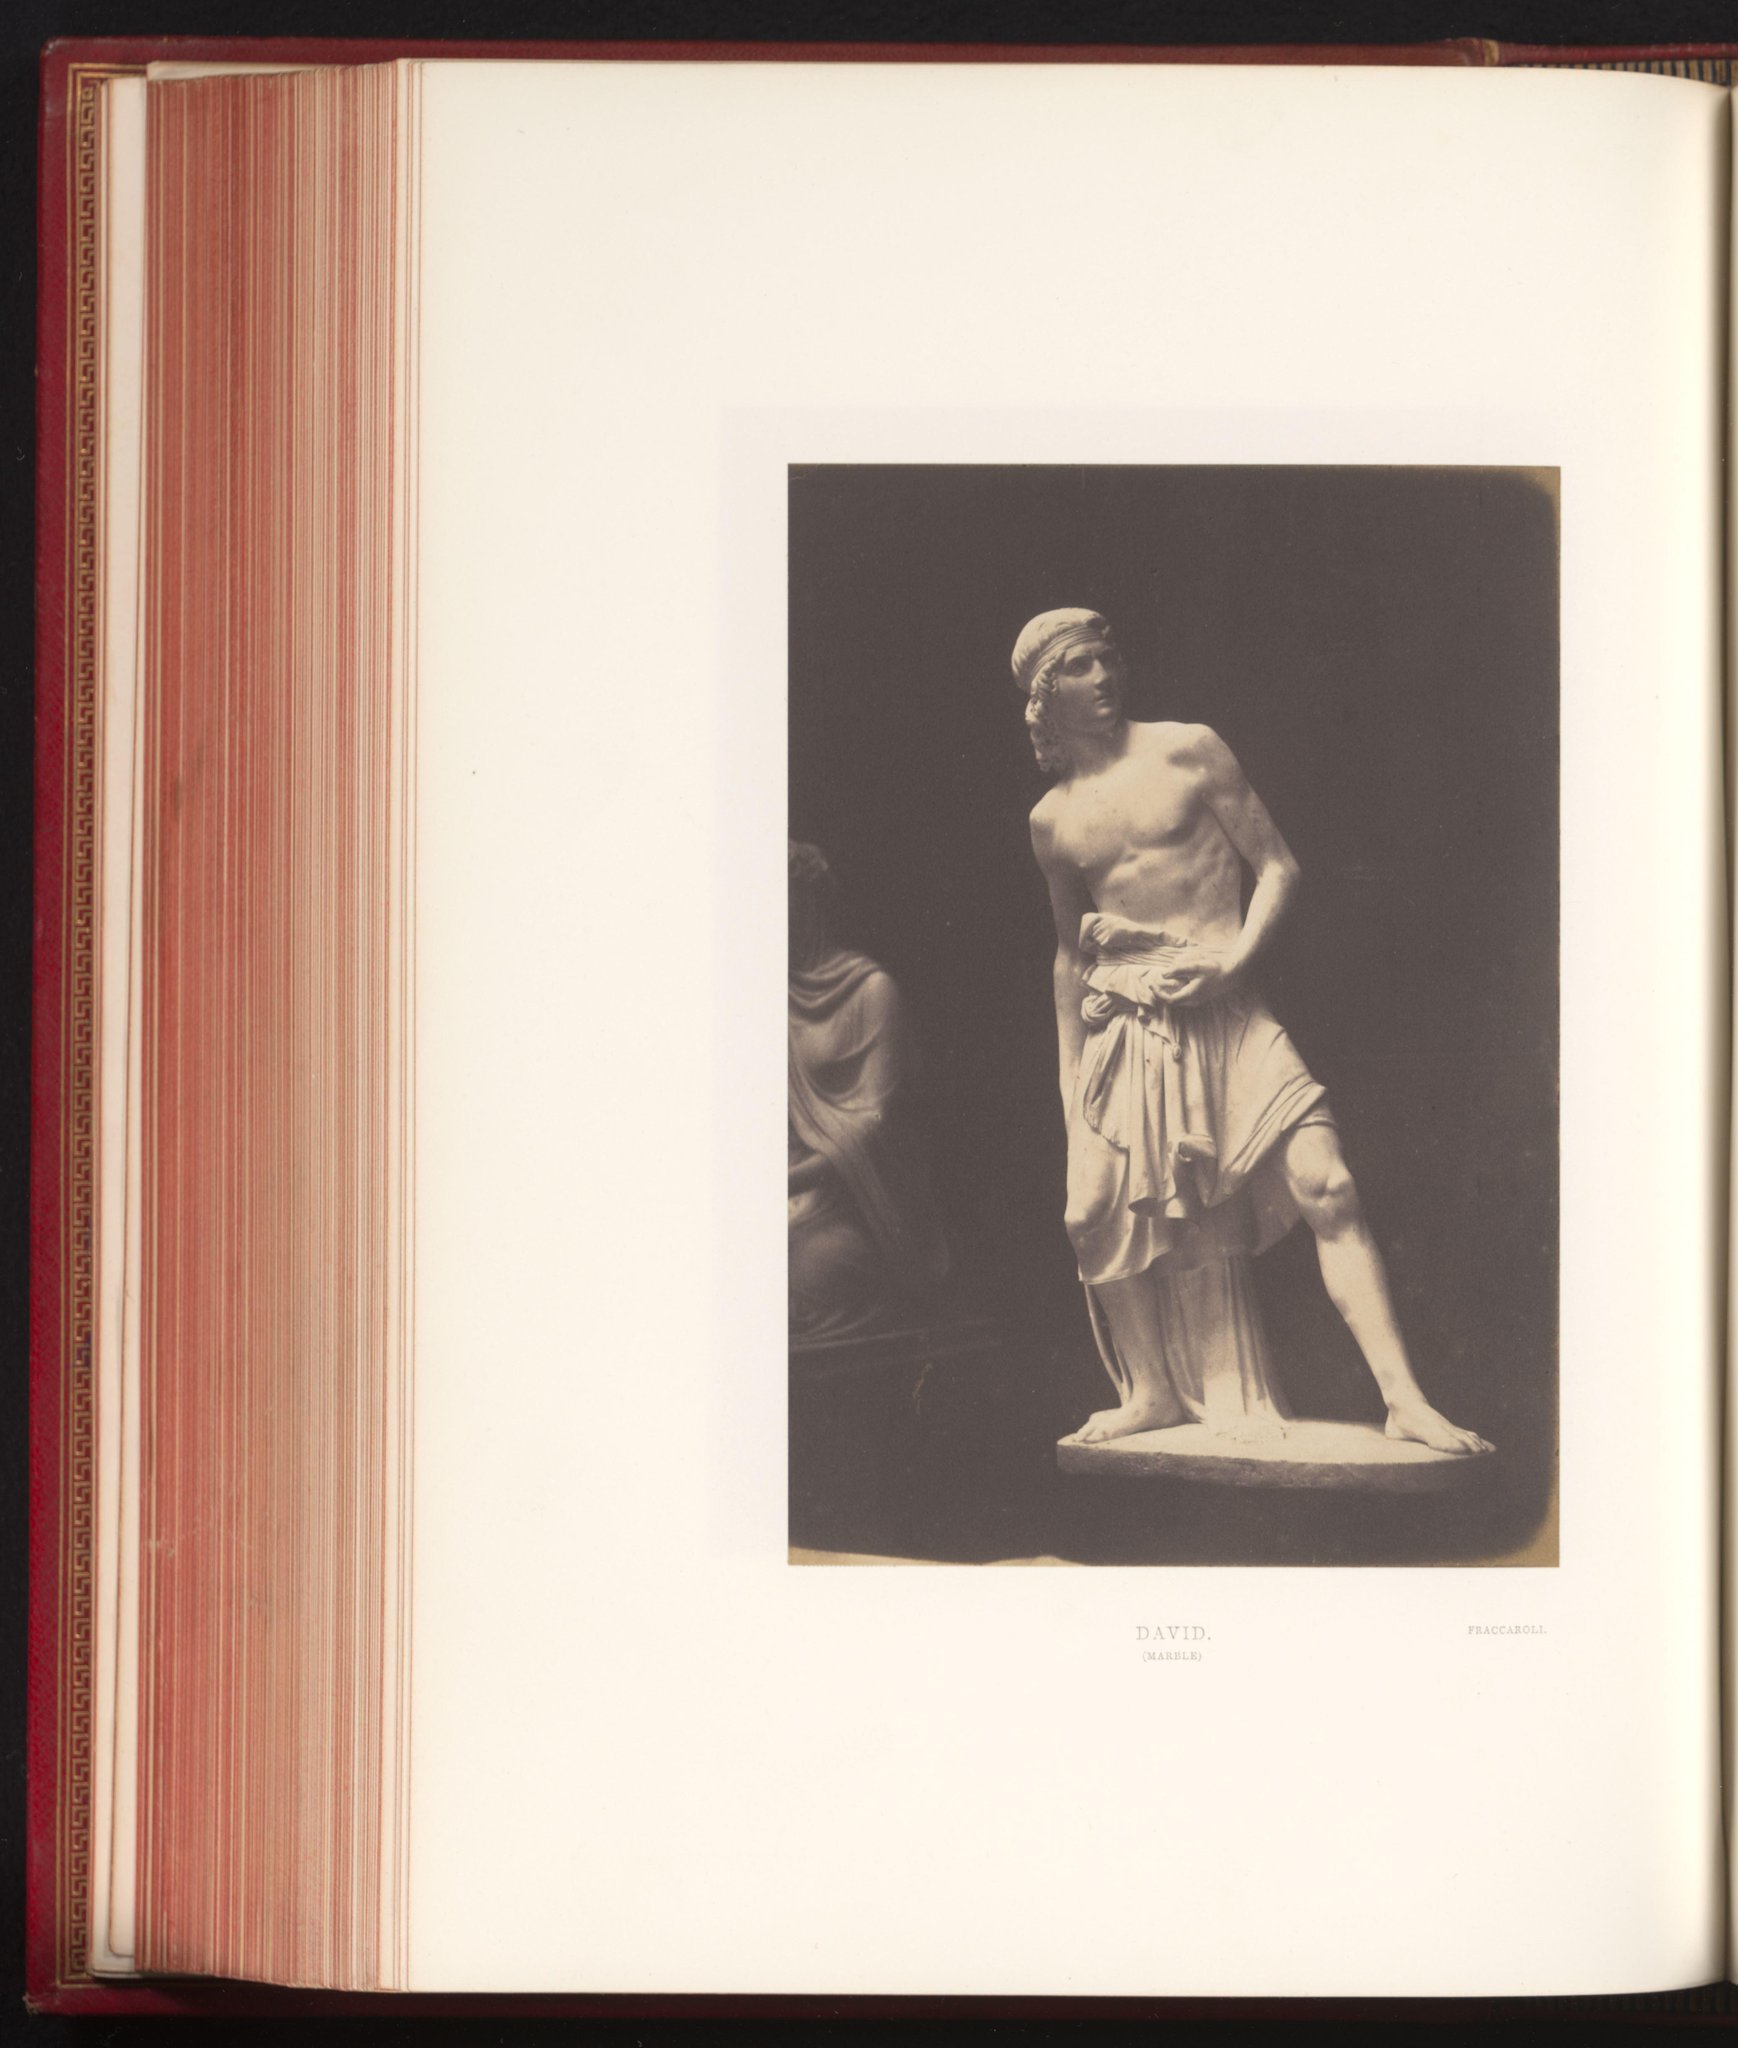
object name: page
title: David. (Marble) Fraccaroli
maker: Anonymous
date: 1851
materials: photographic support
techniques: salted paper print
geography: london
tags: story of david, piece of sculpture, reproduction of a piece of sculpture, london